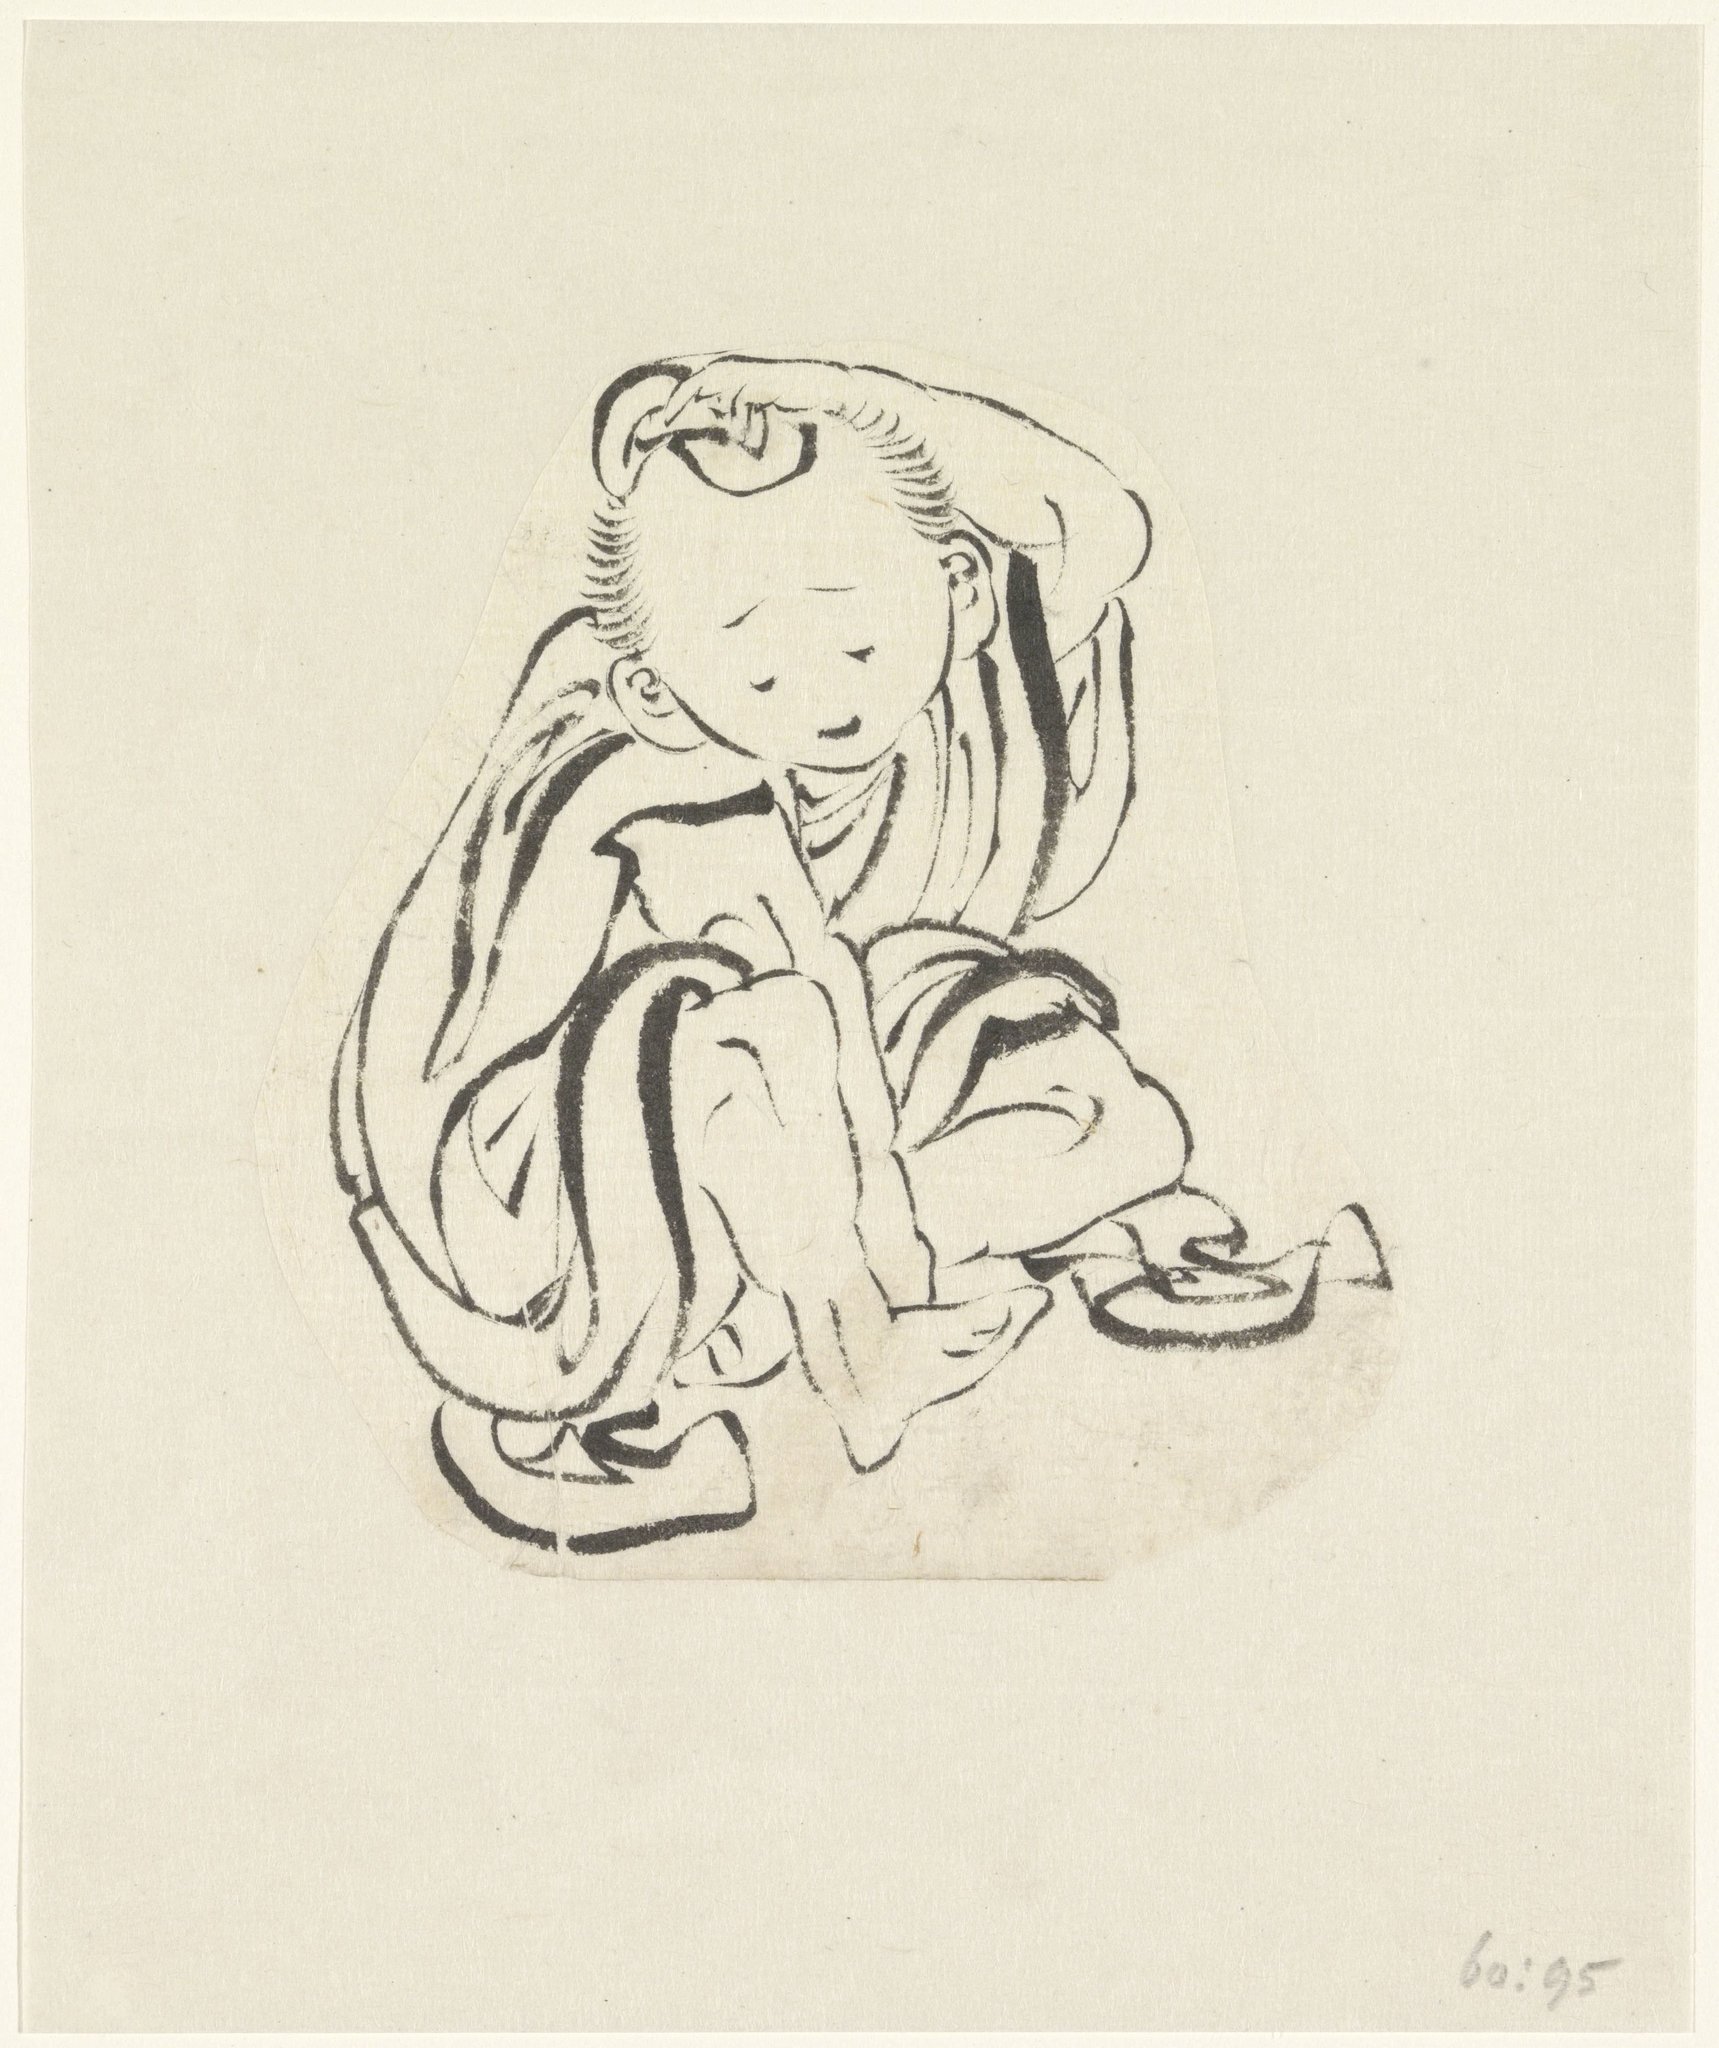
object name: drawing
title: Zittende man die zich met een doek op het hoofd wrijft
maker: totoya hokkei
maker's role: print maker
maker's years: 1790-1850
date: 1791-1850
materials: paper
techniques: brush